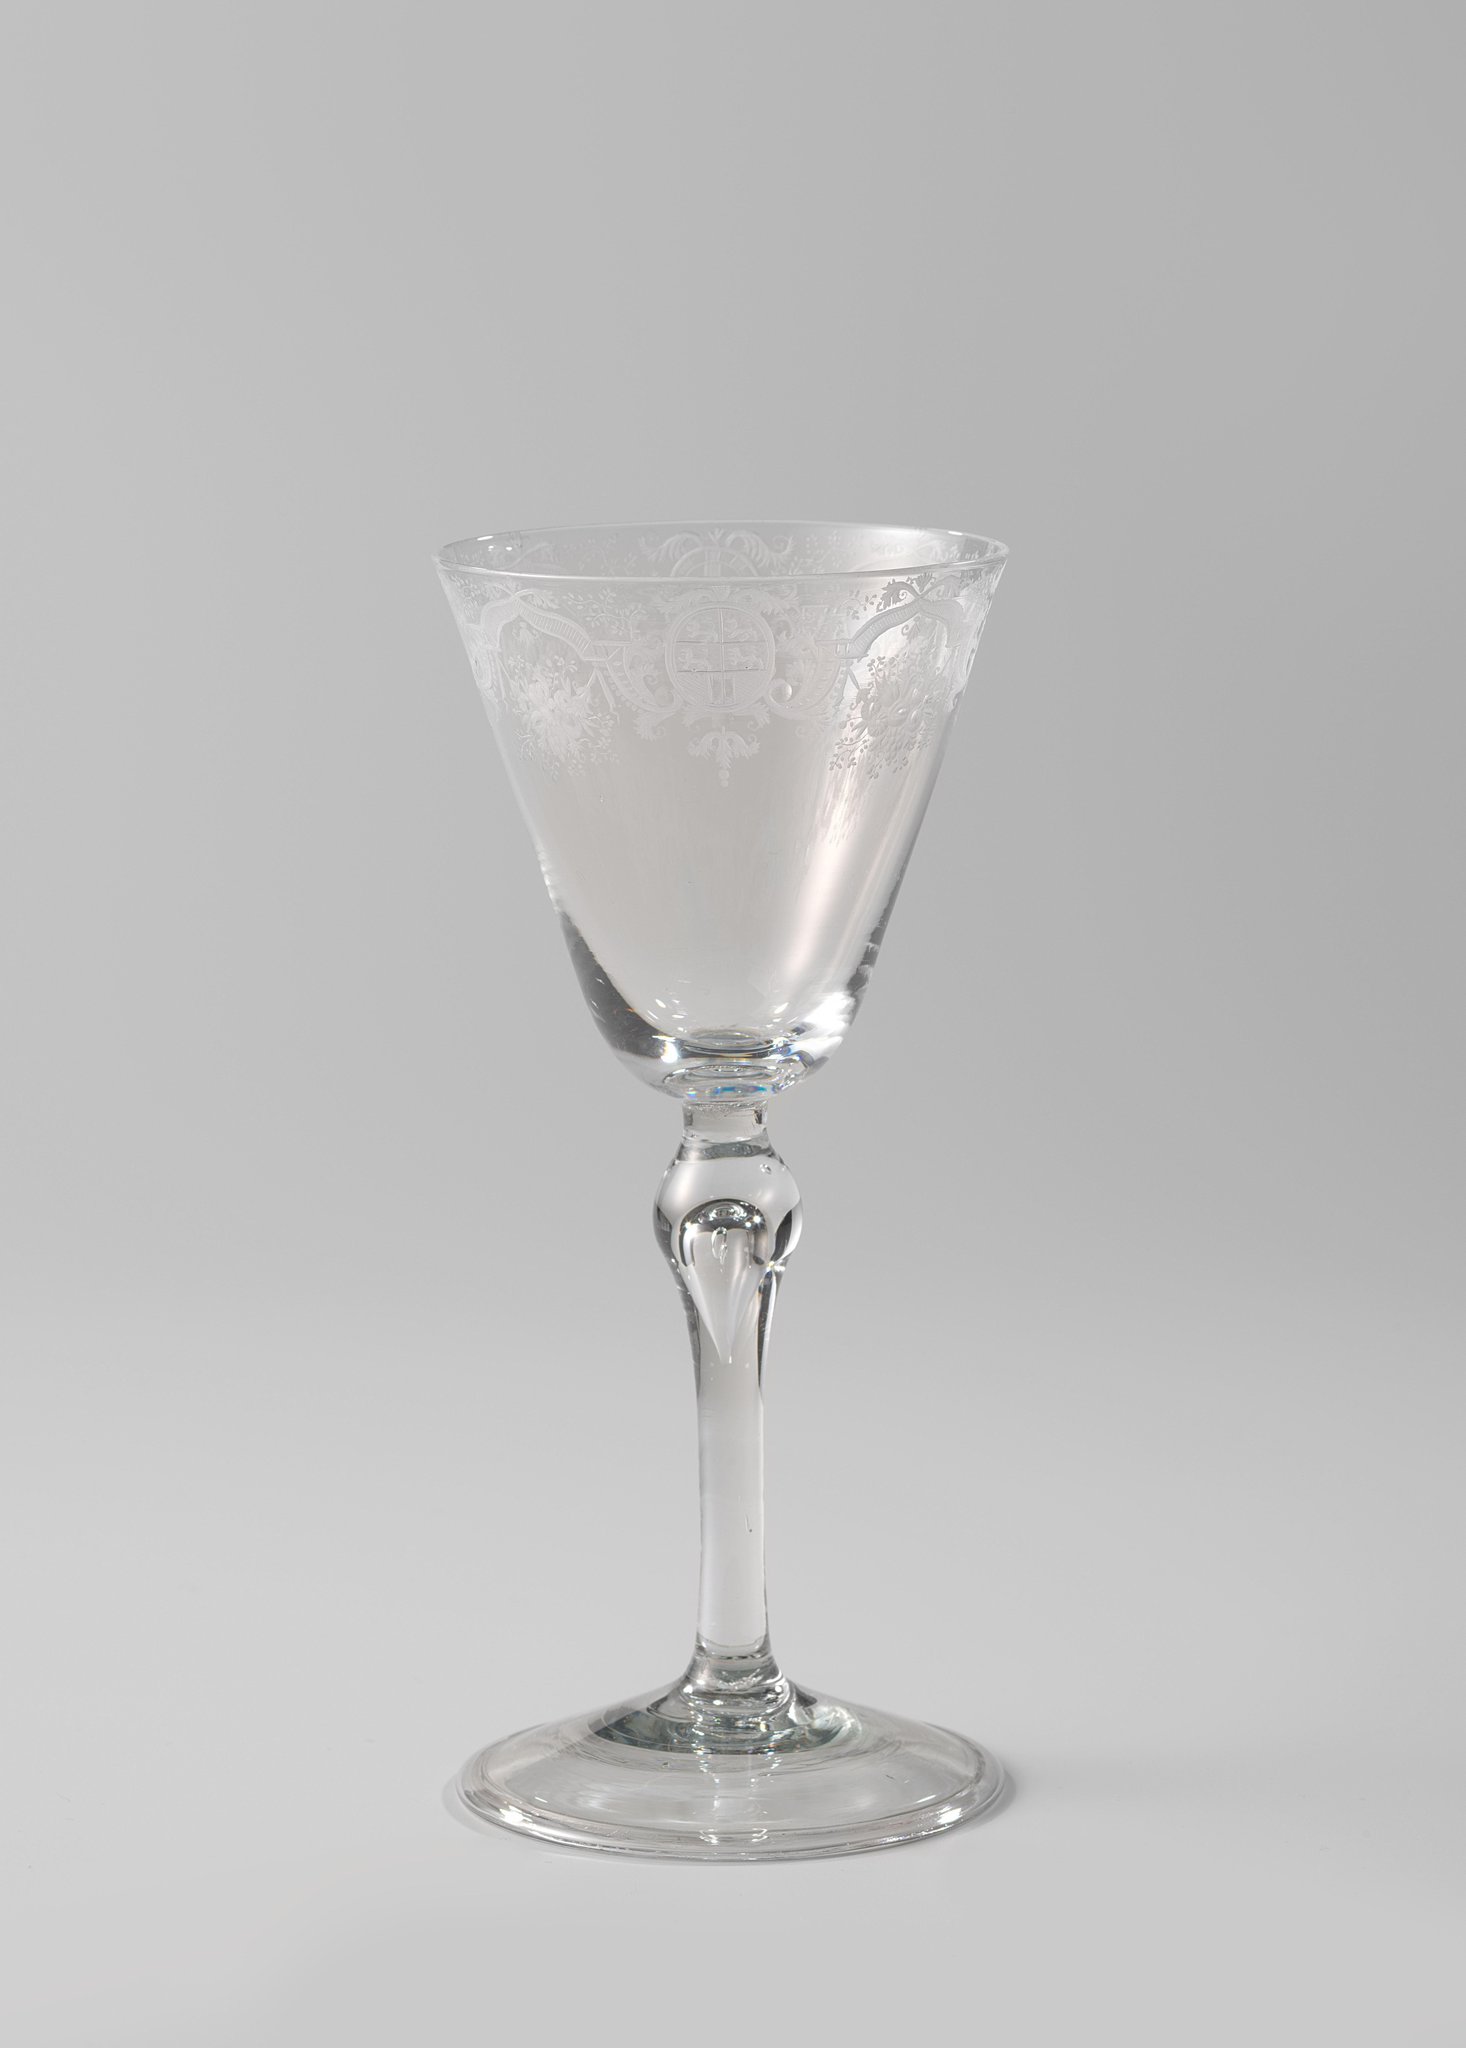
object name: goblet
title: Kelkglas met de wapens van Rotterdam, Schiedam, Dordrecht en Delft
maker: Anonymous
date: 1725-1750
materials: glass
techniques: glassblowing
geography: rotterdam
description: Coats of arms of Rotterdam, Schiedam, Dordrecht and Delft, c. 1725 - 1750. A.J. Enschedé bequest, 1896.